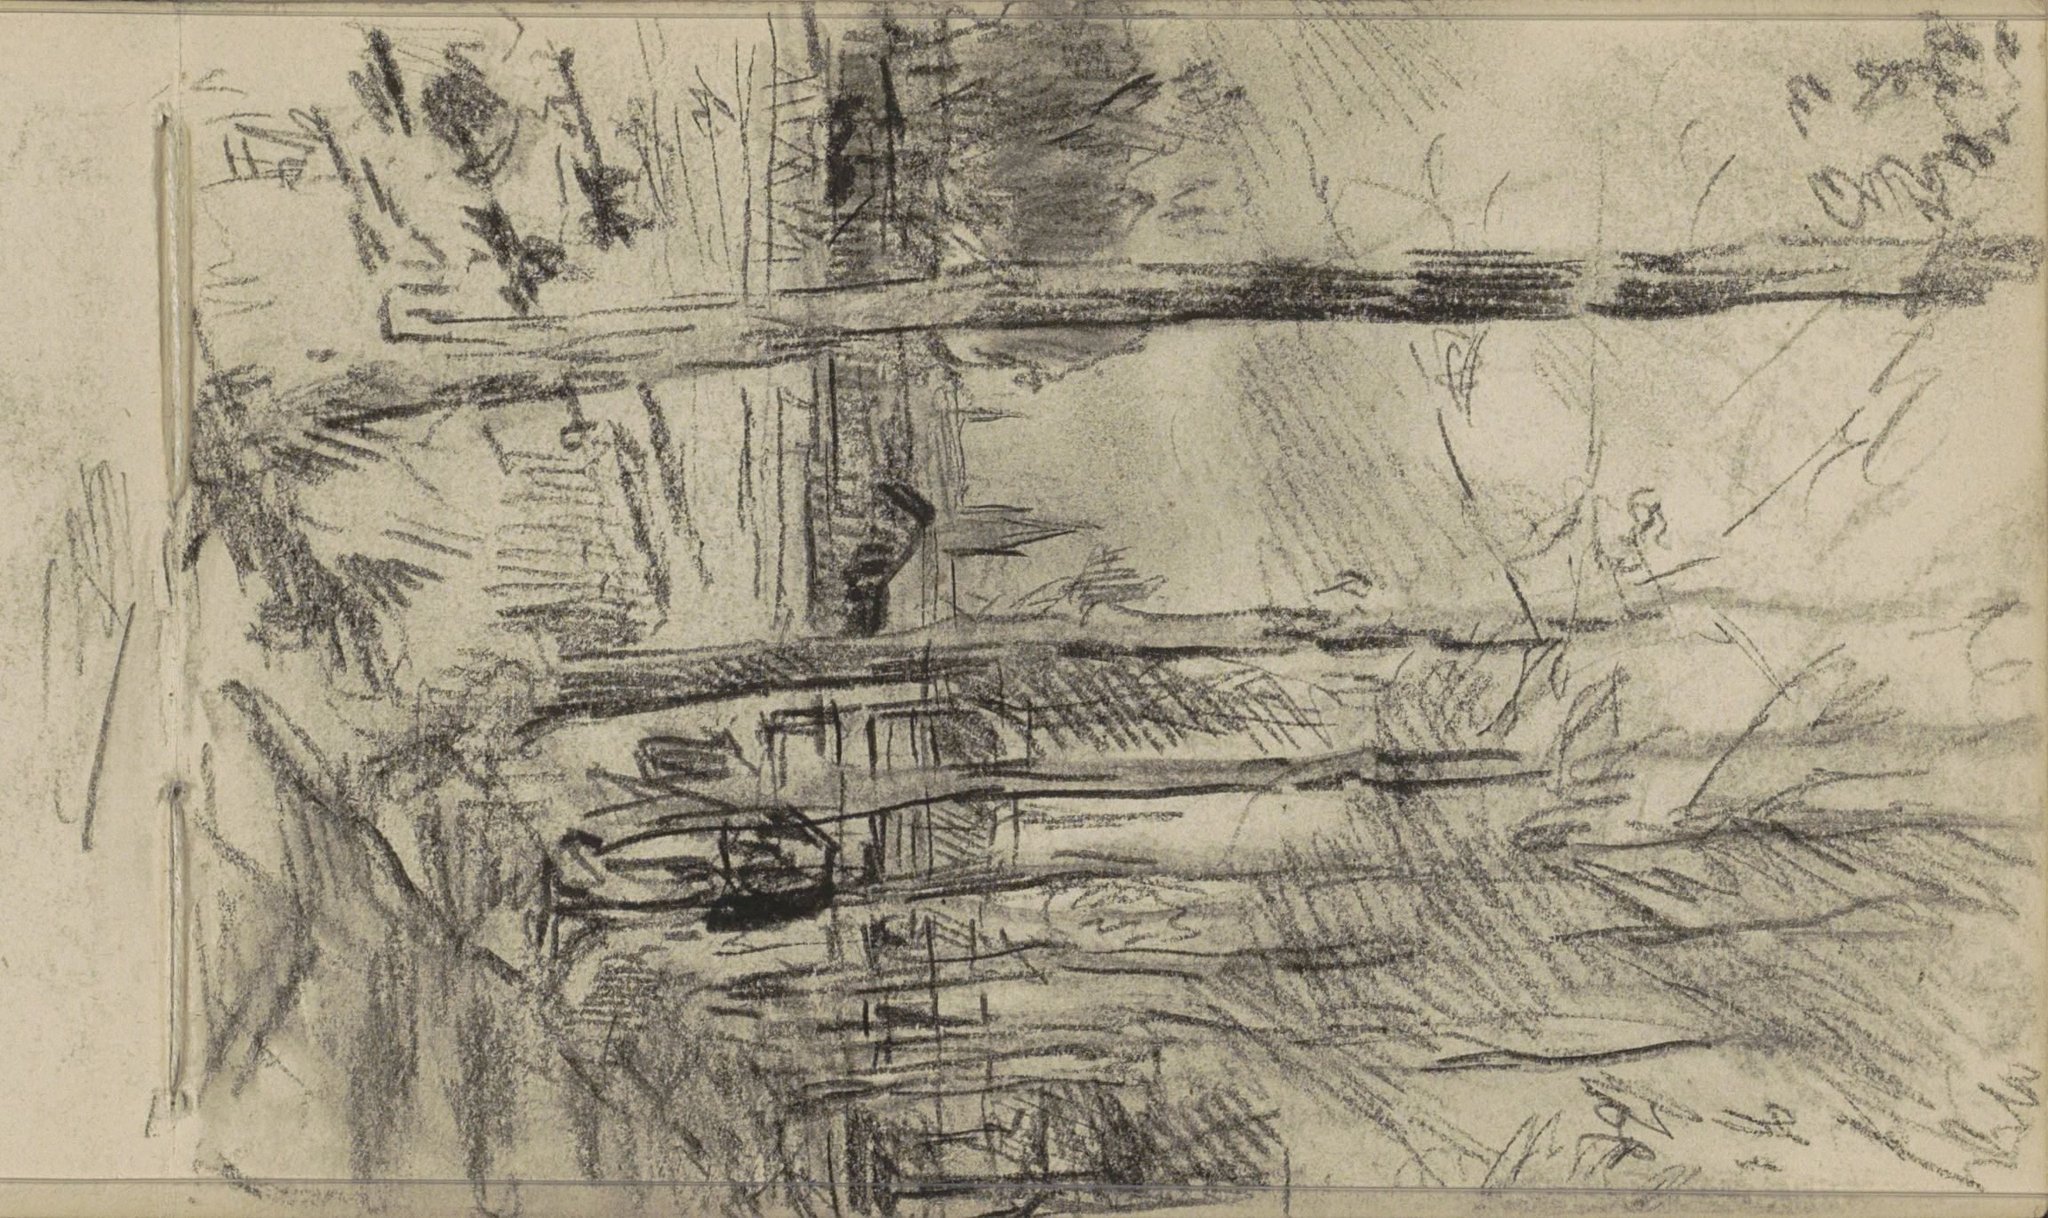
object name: sketchbook leaf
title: Landschap met een kerktoren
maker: johan antonie de jonge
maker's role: draughtsman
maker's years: 1864-1927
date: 1909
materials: chalk, paper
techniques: stumping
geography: south holland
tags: road, path, landscapes (+ landscape with figures, staffage), parts of church exterior and annexes: tower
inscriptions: kleurnotitie, handgeschreven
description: Vooraan een figuur op een pad langs bomen. In de verte een kerktoren. Blad 5 recto uit een schetsboek met 31 bladen.